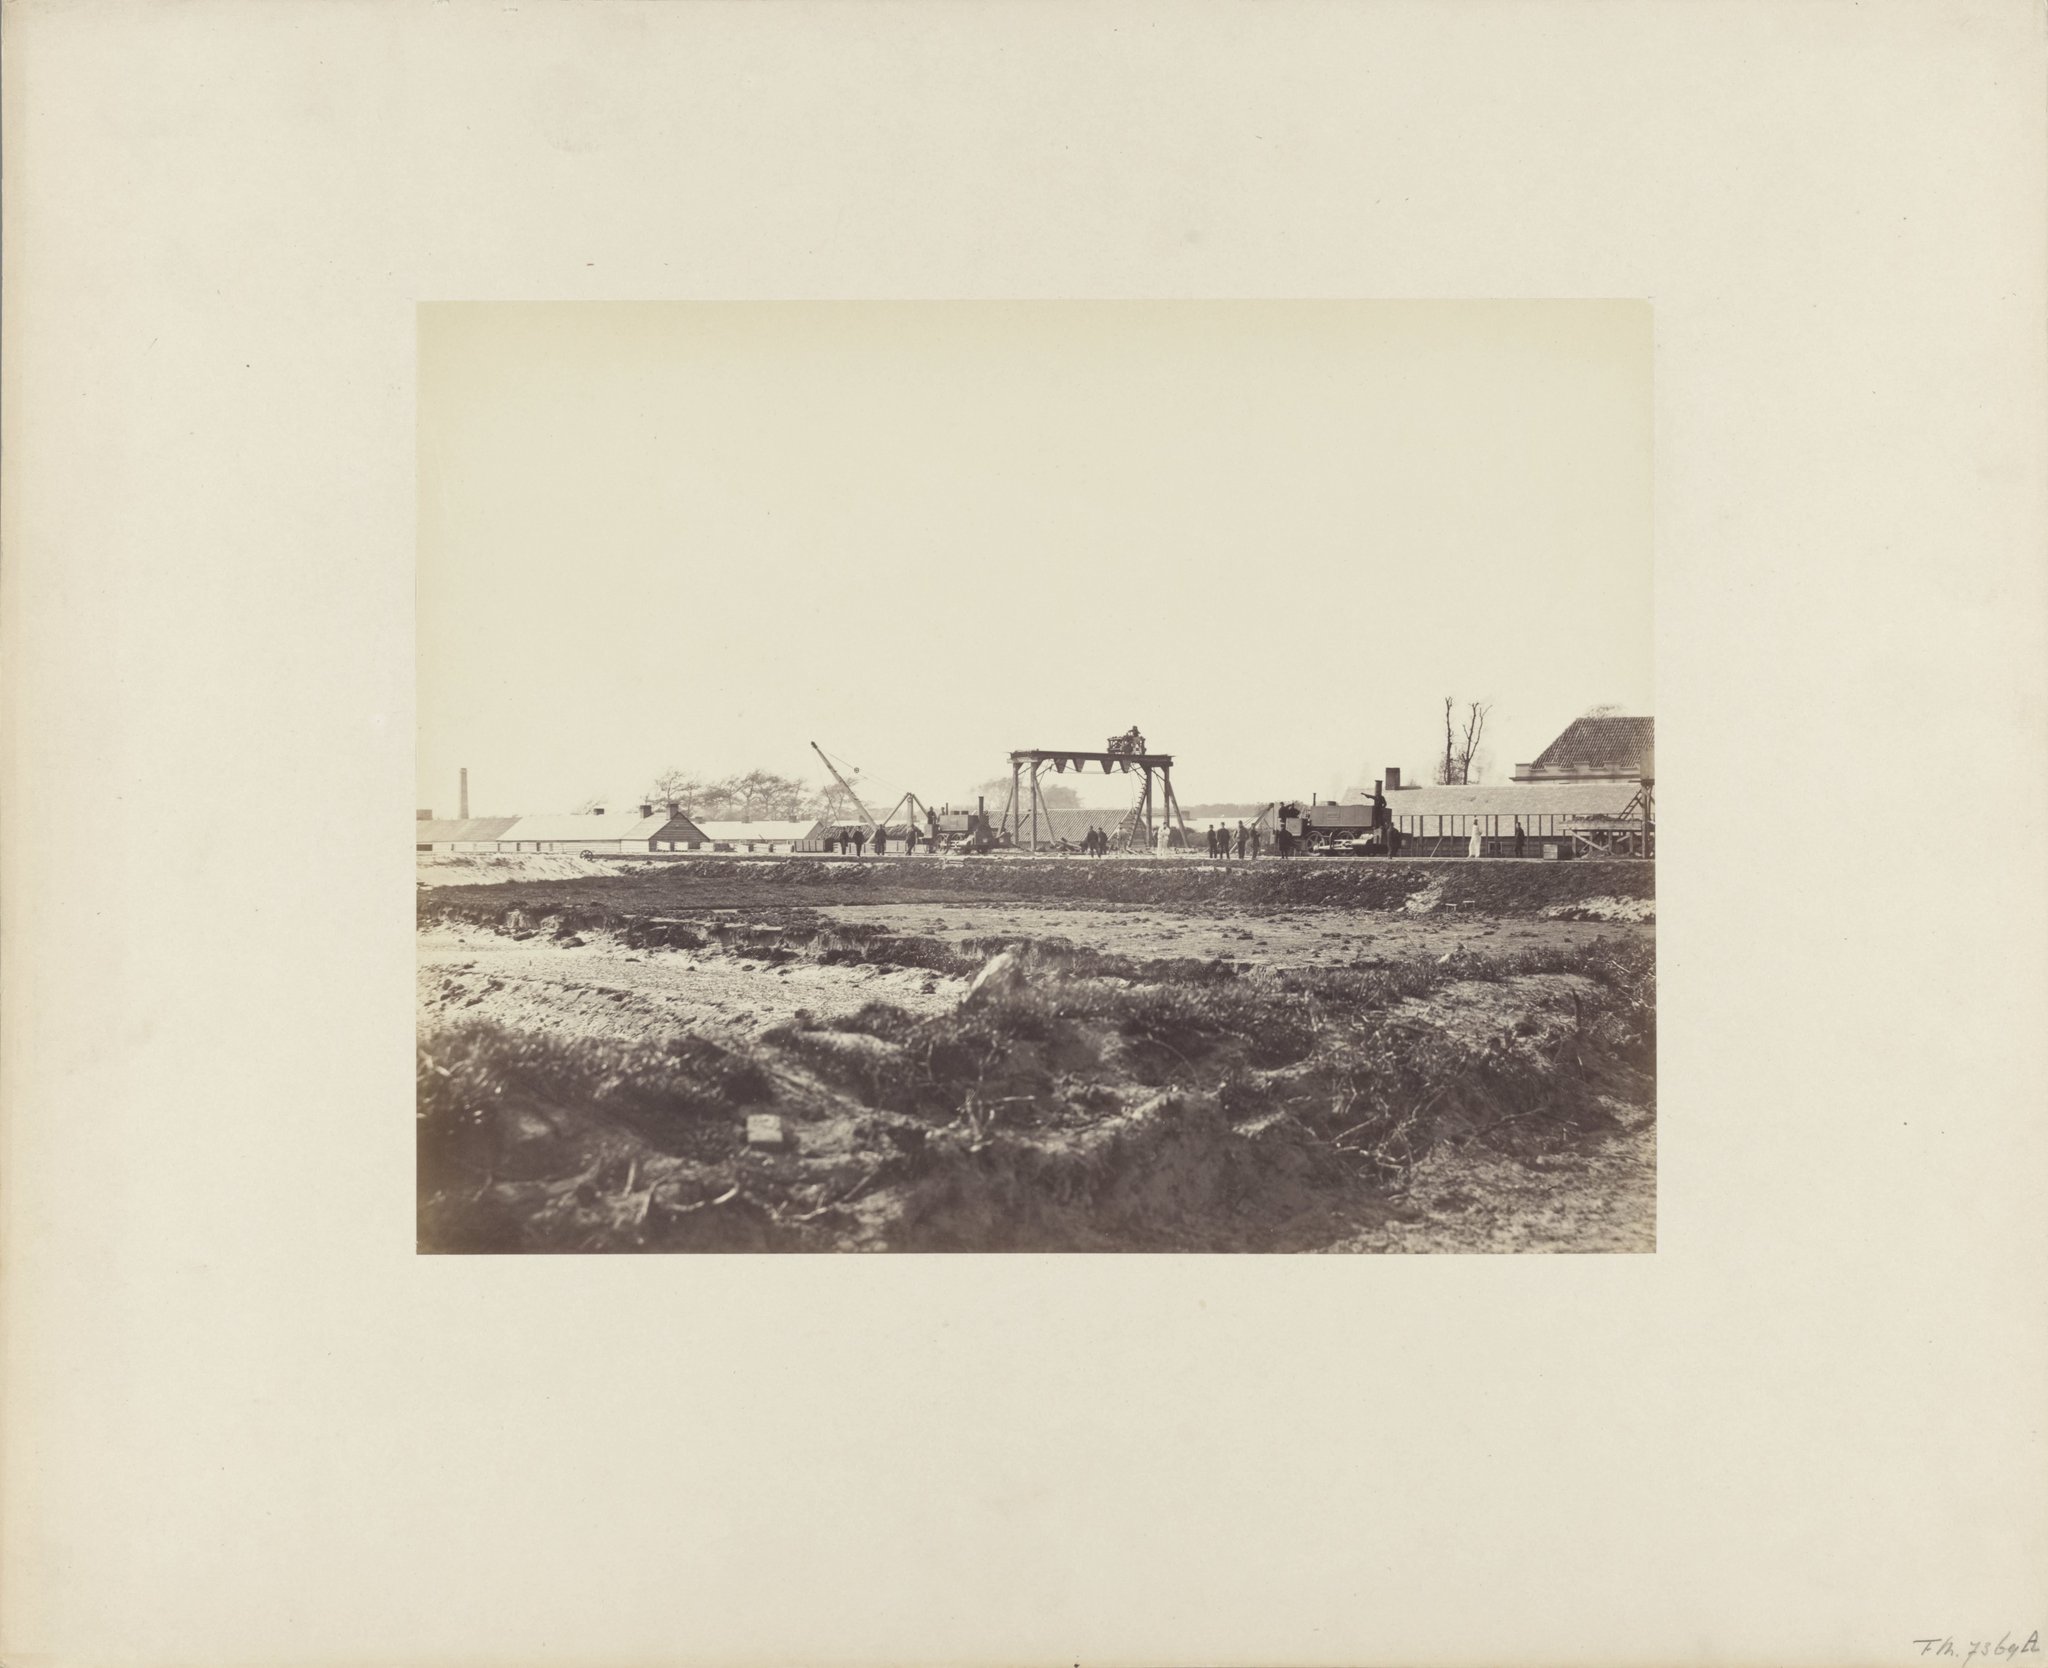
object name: photograph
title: Aanleg Noordzeekanaal, 1866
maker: rudolph guicherit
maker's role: fotograaf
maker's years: 1837-1897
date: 1866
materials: cardboard, paper, photographic support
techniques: albumen print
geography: netherlands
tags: construction of canal, canal, building-site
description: Werkzaamheden tijdens de aanleg van het Noordzeekanaal door Holland op zijn smalst, 1866.Onderdeel; van een serie van vier foto's van de aanleg van het Noordzeekanaal in 1866.